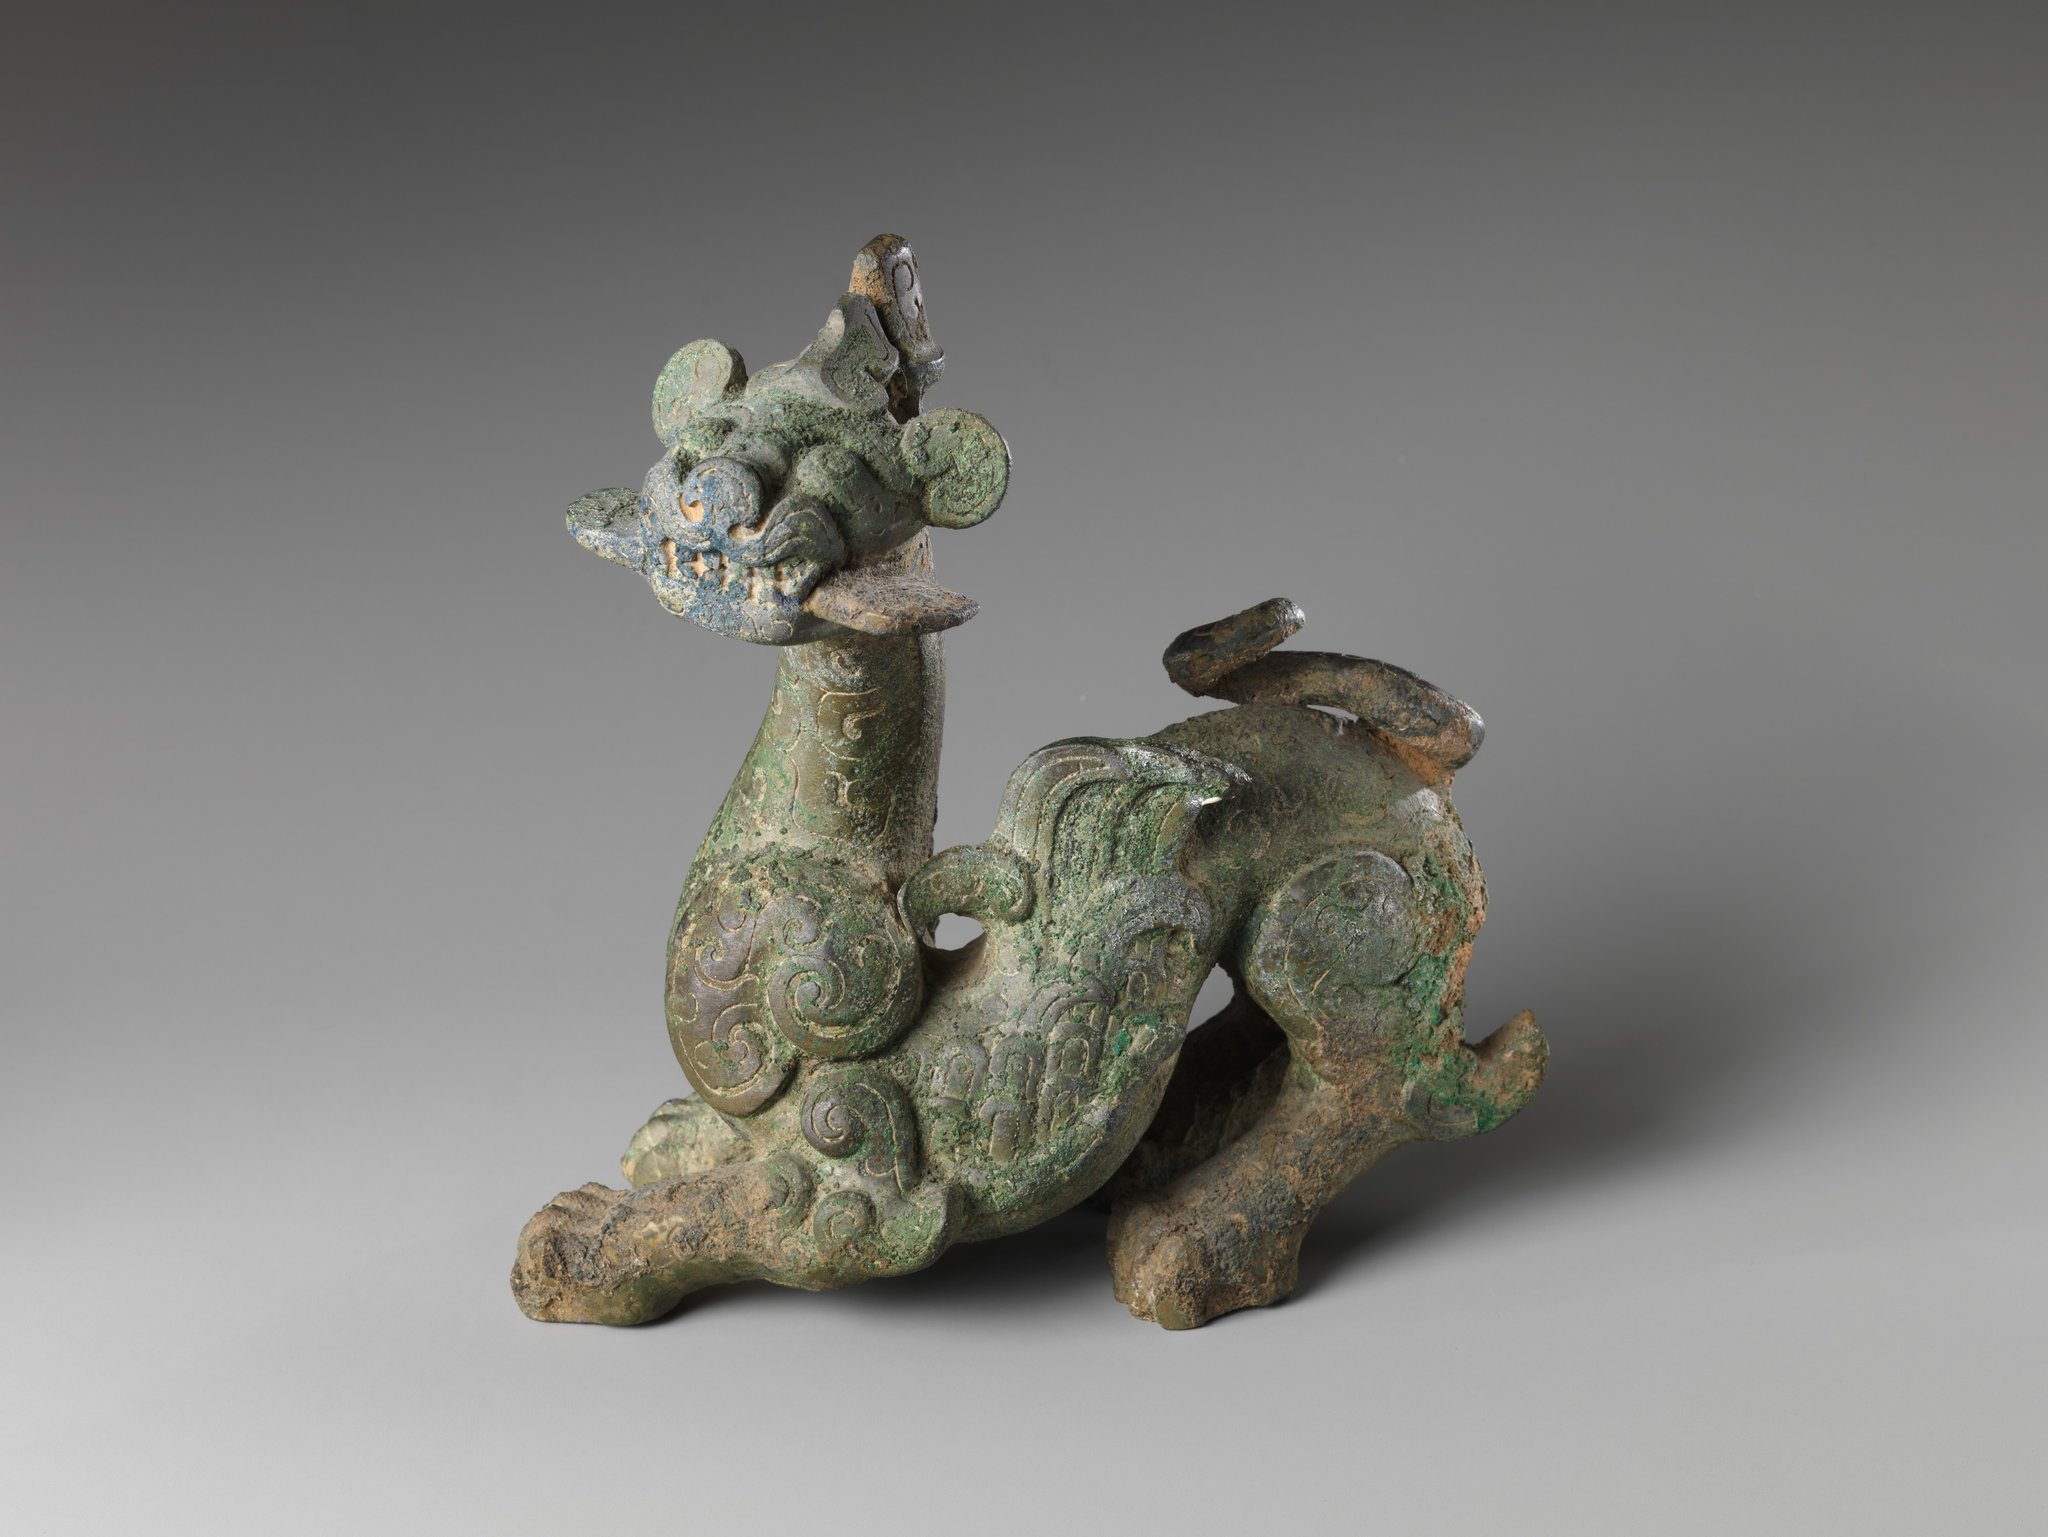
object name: ornament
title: Fantastic winged feline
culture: chinese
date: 400-201 BCE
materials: bronze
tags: animals